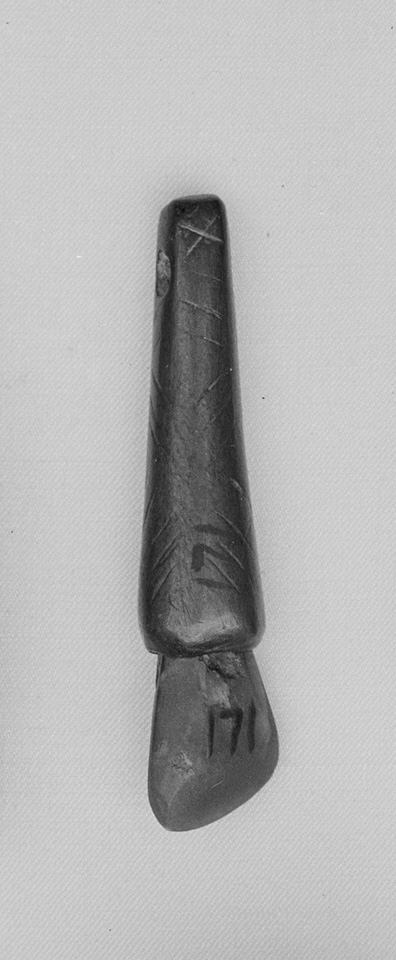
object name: knife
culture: swiss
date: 1902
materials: jade